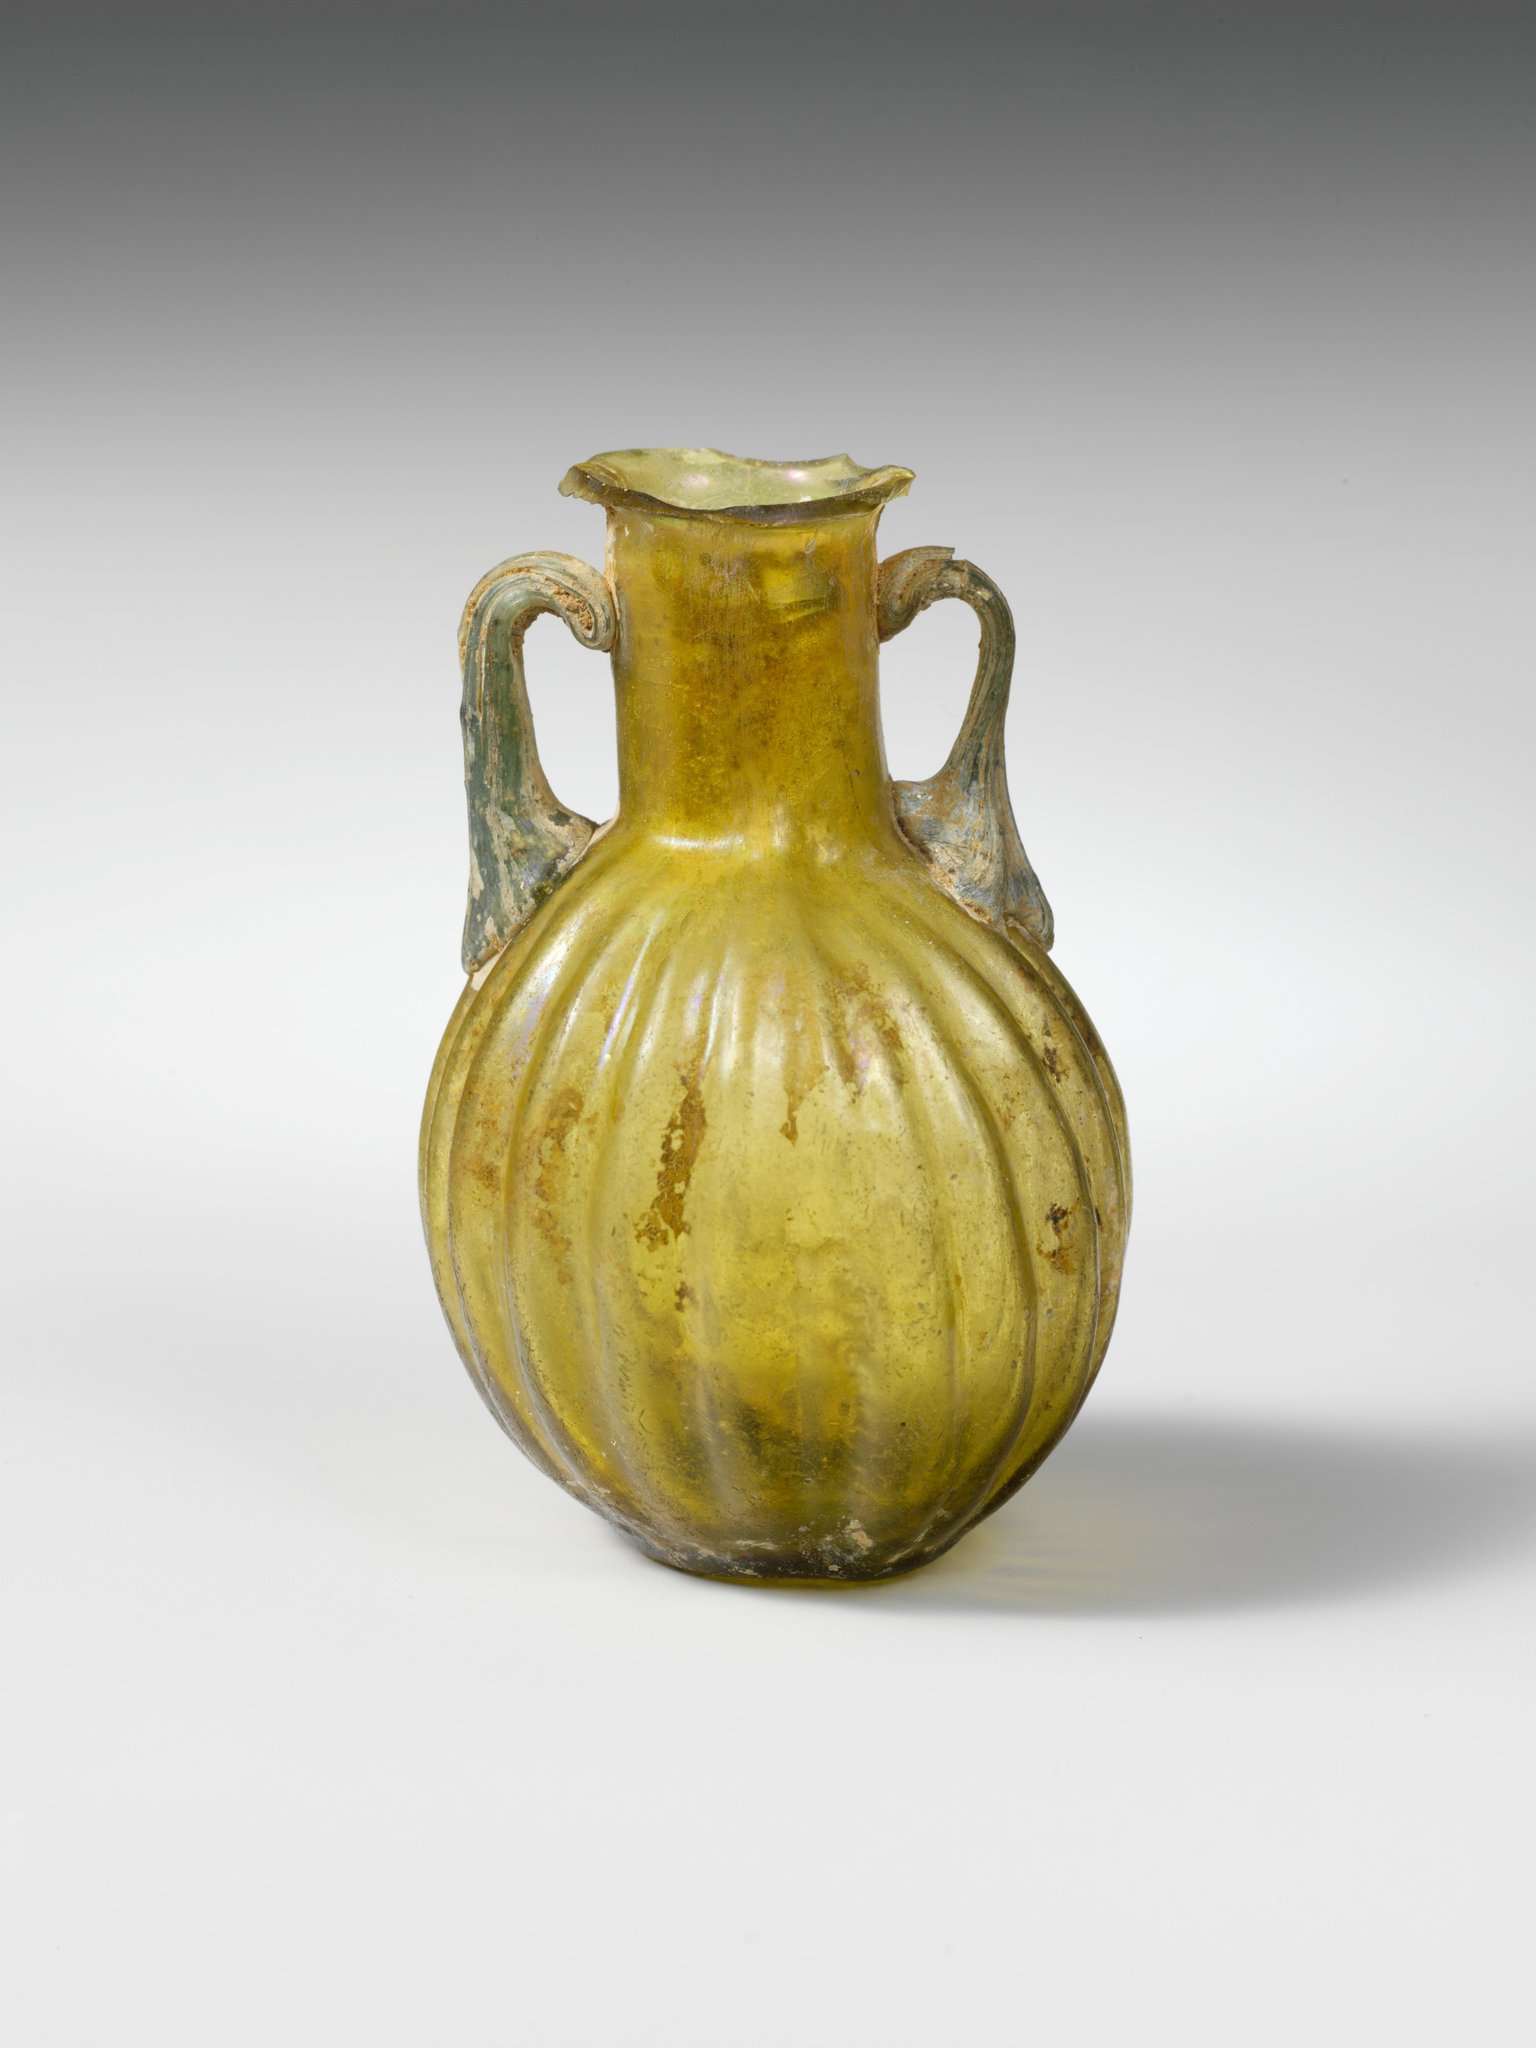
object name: amphoriskos, vertical rib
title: Glass amphoriskos with vertical ribs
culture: roman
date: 1-133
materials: glass